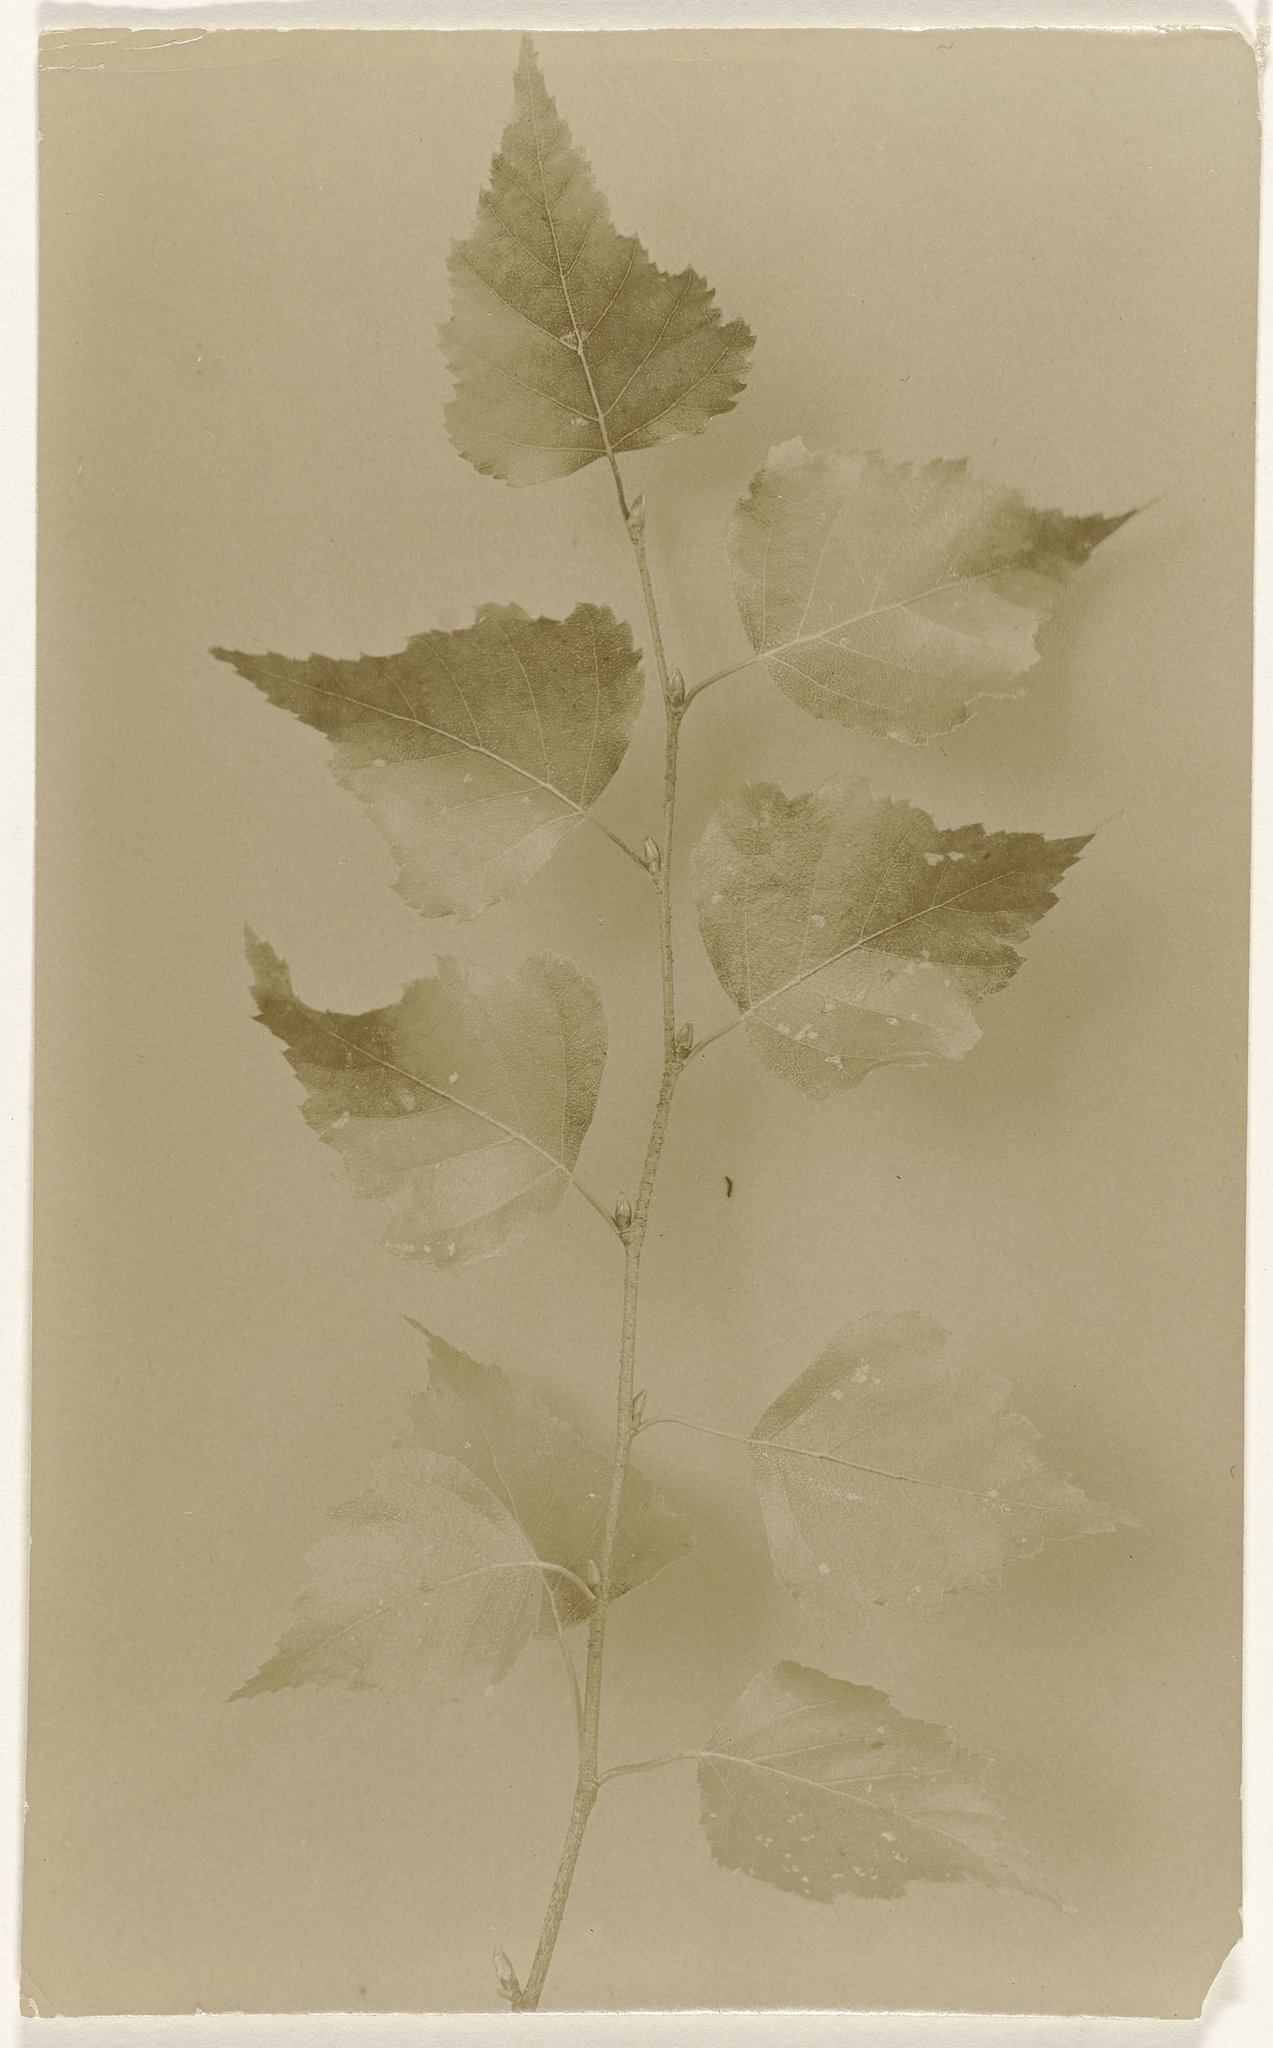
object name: photograph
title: Tak van een ruwe berk tegen een egale achtergrond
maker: richard tepe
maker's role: fotograaf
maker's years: 1864-1952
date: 1900-1940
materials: photographic support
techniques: gelatin silver print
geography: netherlands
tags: trees: birch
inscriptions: : ‘Bovenzijde / Ruwe Berk / Bladerentakje’, signature: ‘foto / R. Tepe’